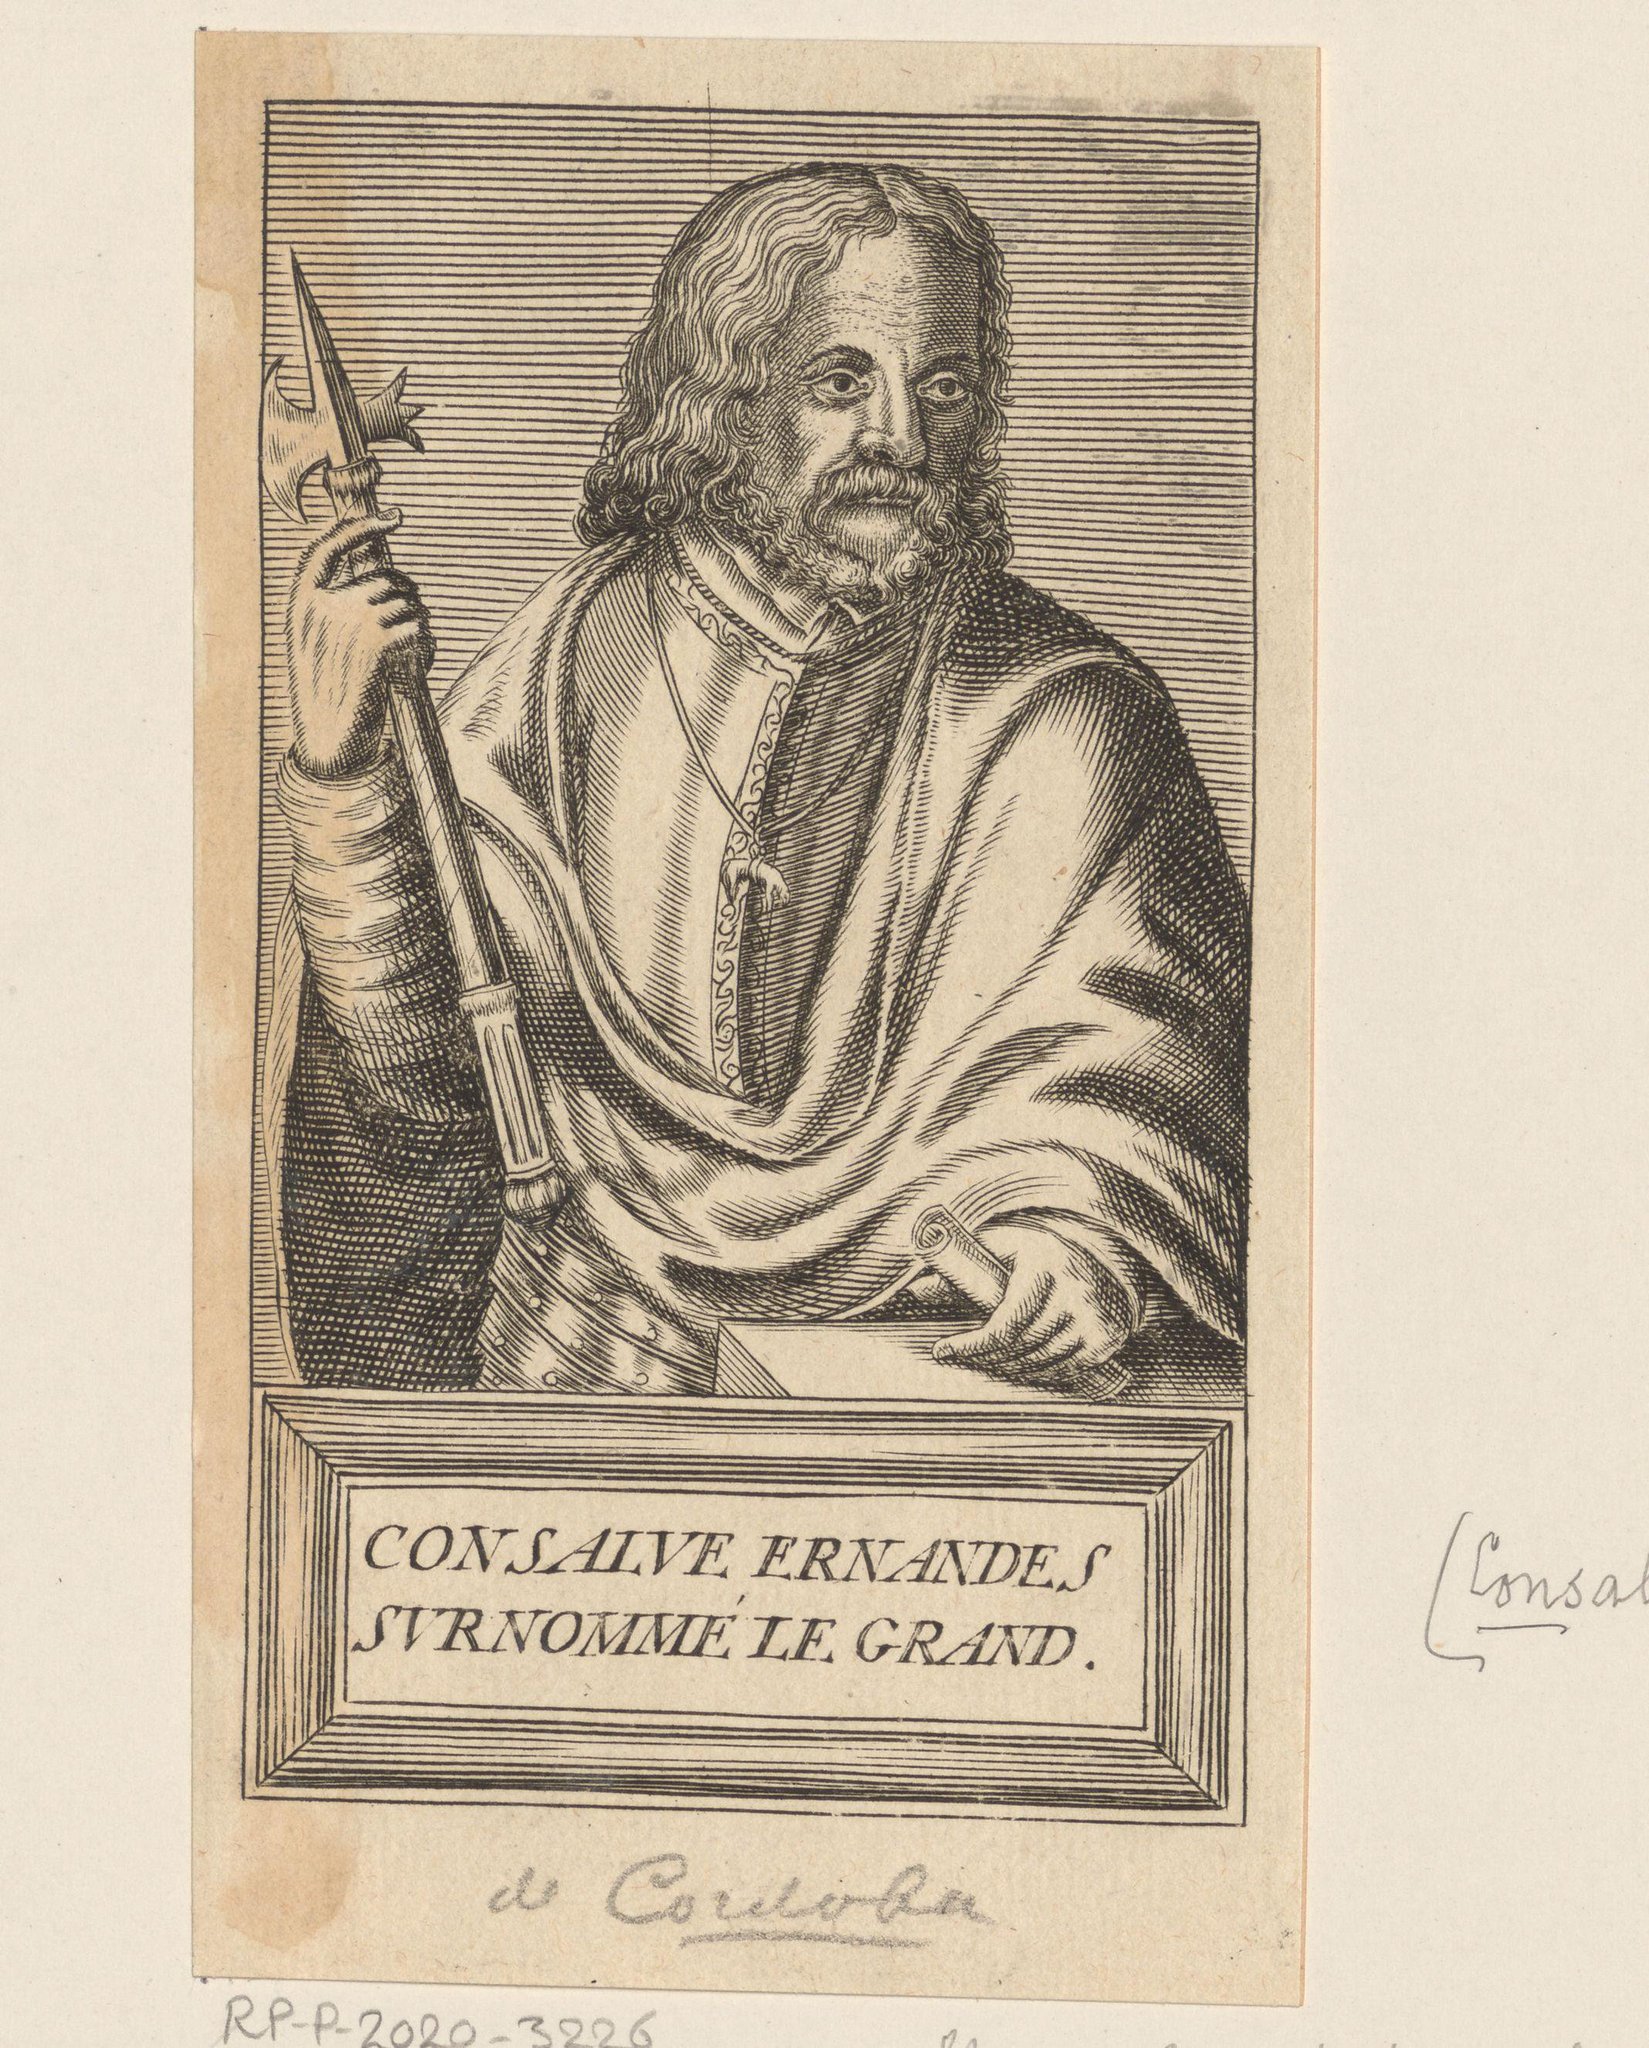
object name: print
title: Portret van Gonzalo Fernández de Córdoba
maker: Anonymous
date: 1671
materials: paper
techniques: engraving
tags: historical persons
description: Prent mogelijk uit: Thevet, Andre. Histoire des plus illustres et sçavans hommes de leurs siècles (...). Parijs: François Mauger, 1671, dl. 5, tussen p. 34 en 35.